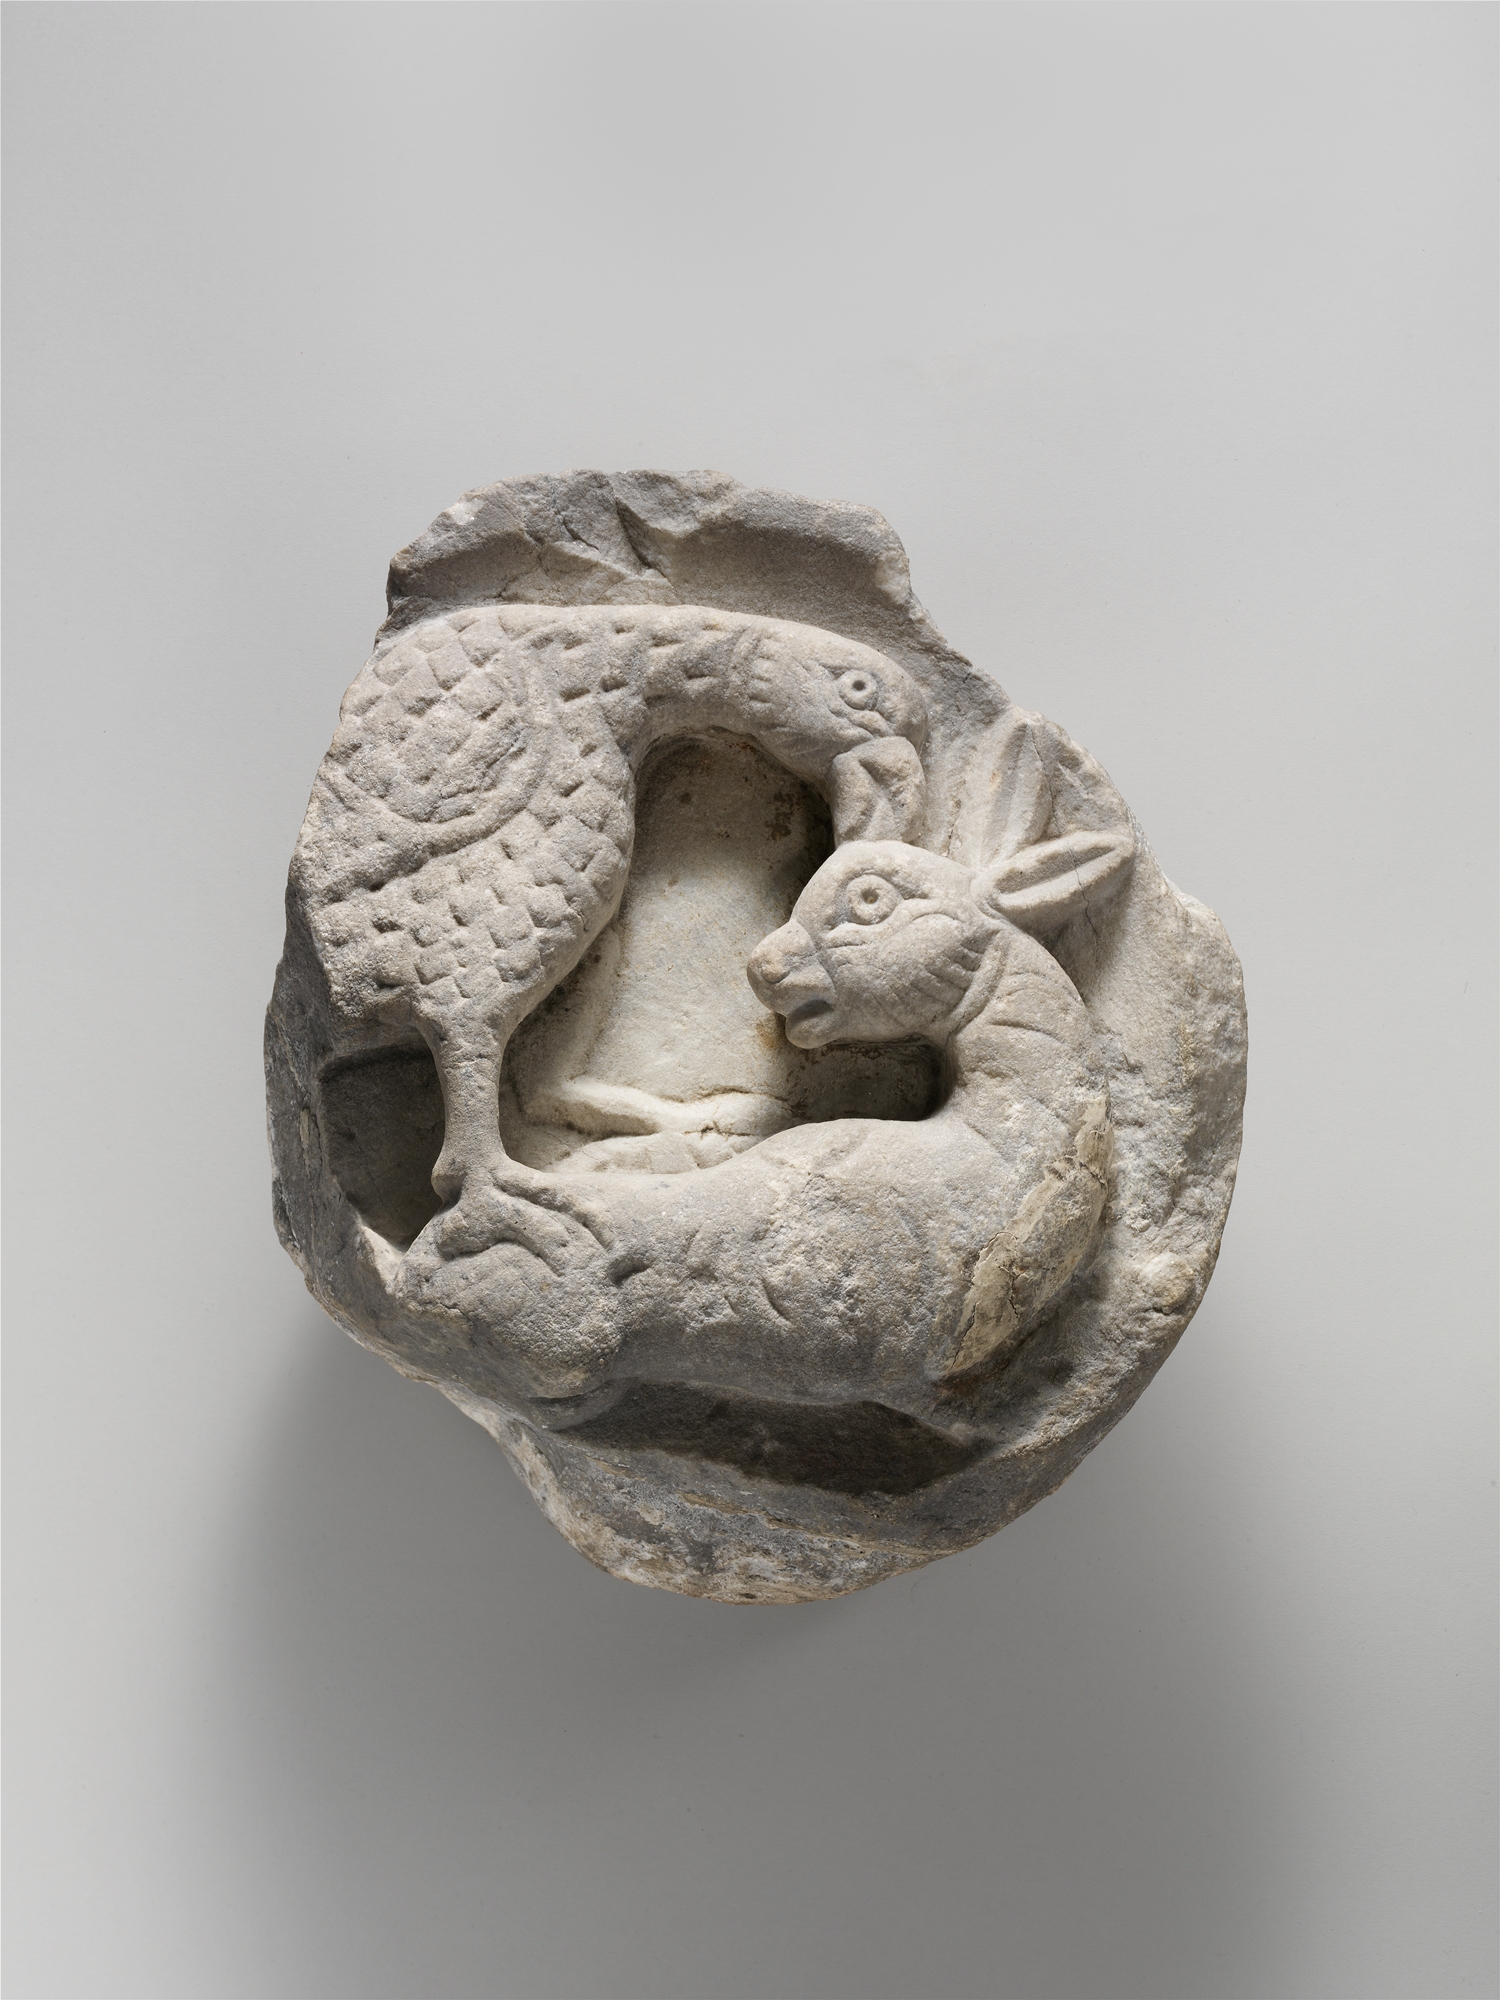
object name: roundel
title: Decorative Roundel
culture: italian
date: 1101-1300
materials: marble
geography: italy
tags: animals,birds